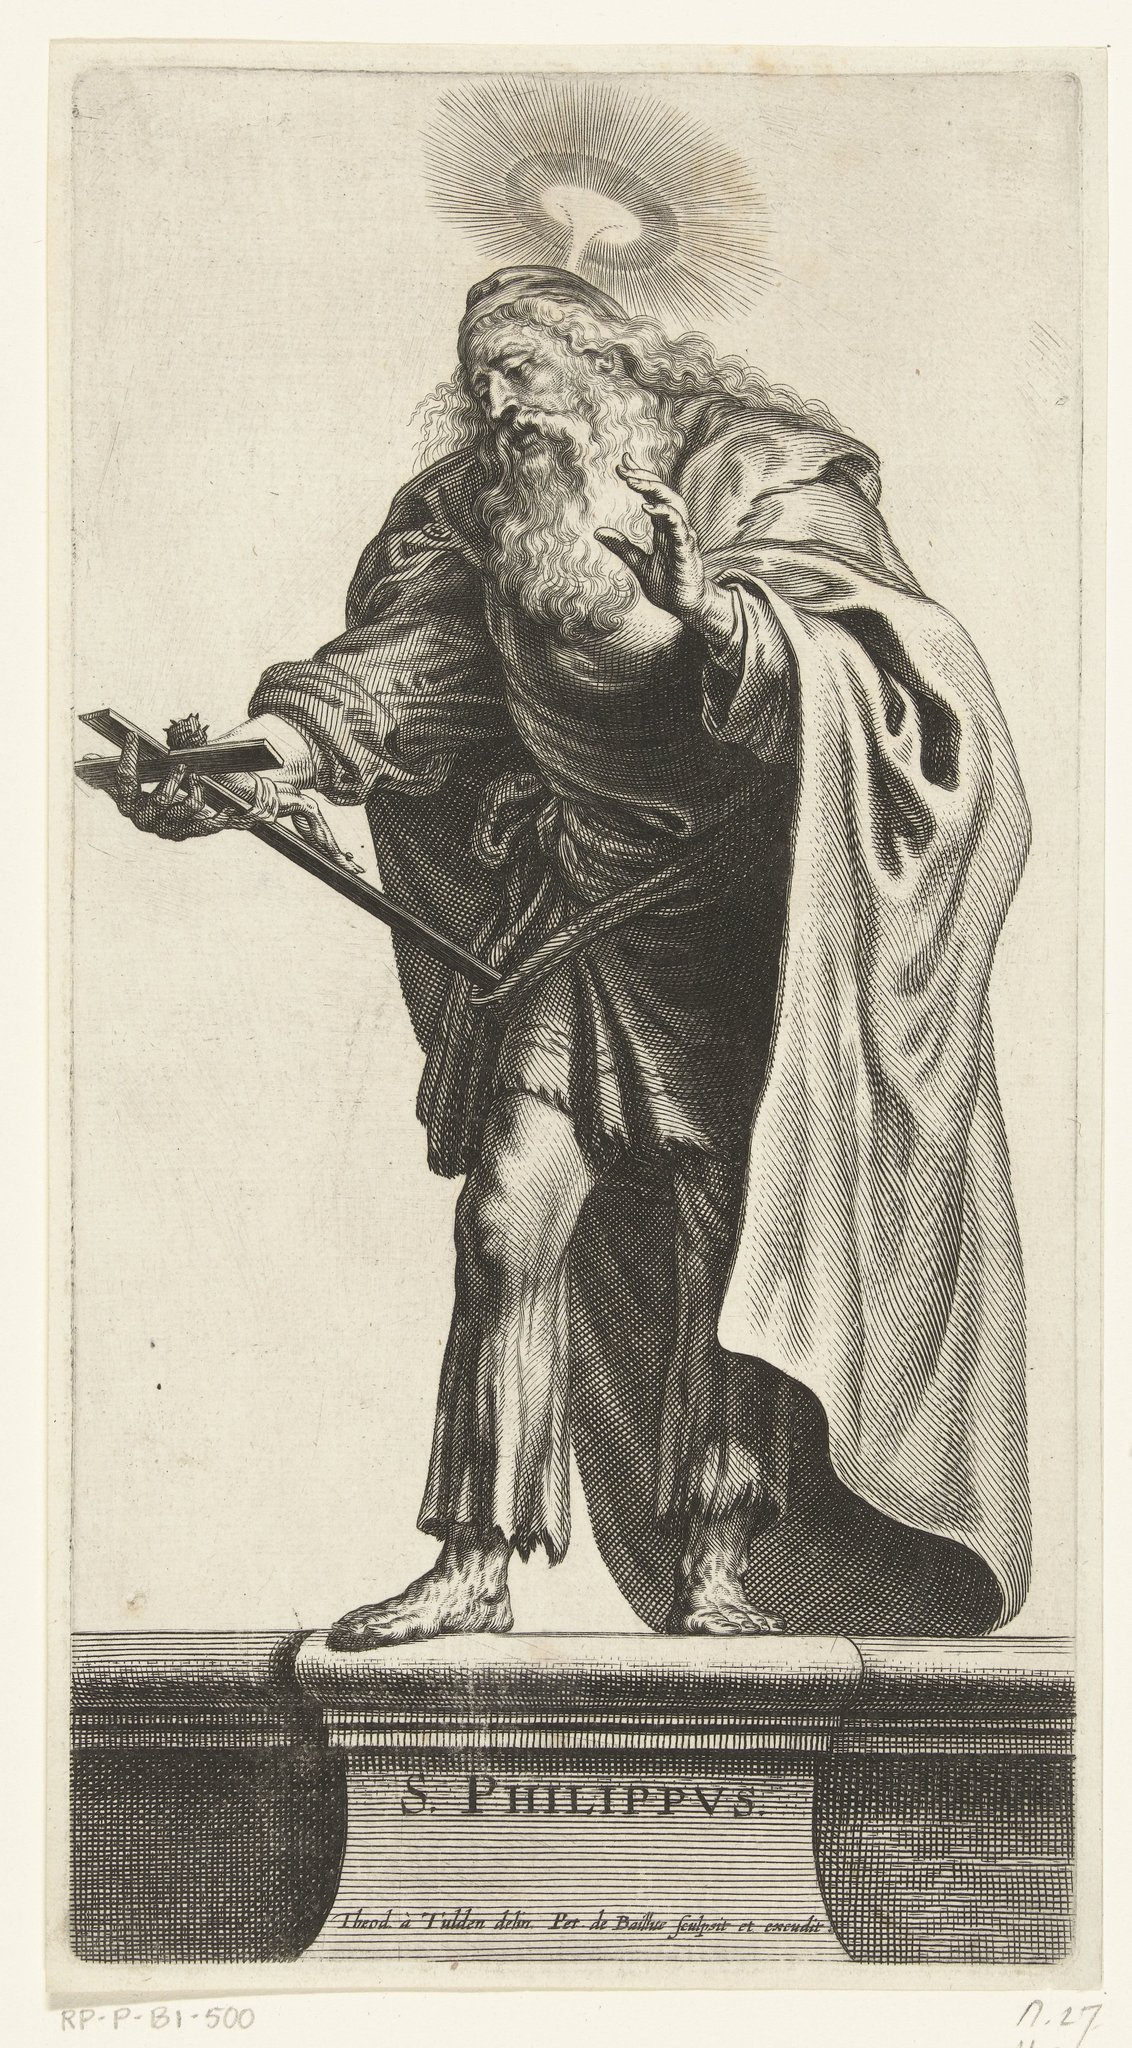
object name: print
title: Christus en Maria en heiligen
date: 1623-1660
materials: paper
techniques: engraving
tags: the apostle philip; possible attributes: book, cross, dish with snake, lance, scroll, stone, sword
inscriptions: collector's mark: Lugt 240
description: Prent naar ontwerp van Theodoor van Thulden uit een serie van zestien prenten met Christus, Maria, de twaalf apostelen en de heiligen Paulus en Jozef.